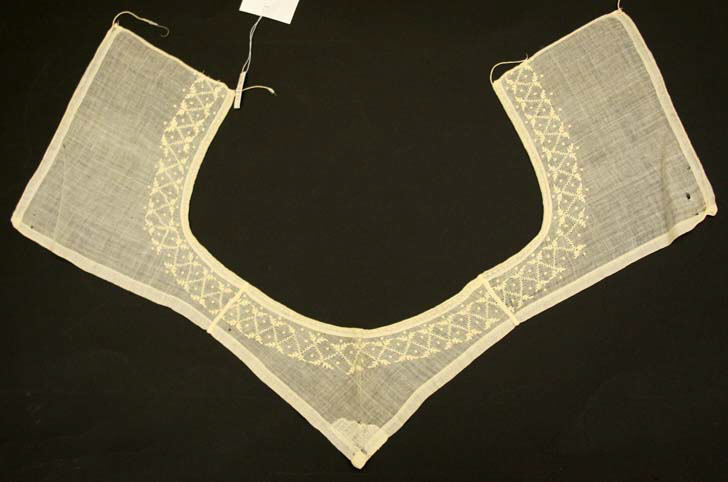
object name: neckpiece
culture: american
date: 1801-1900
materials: cotton